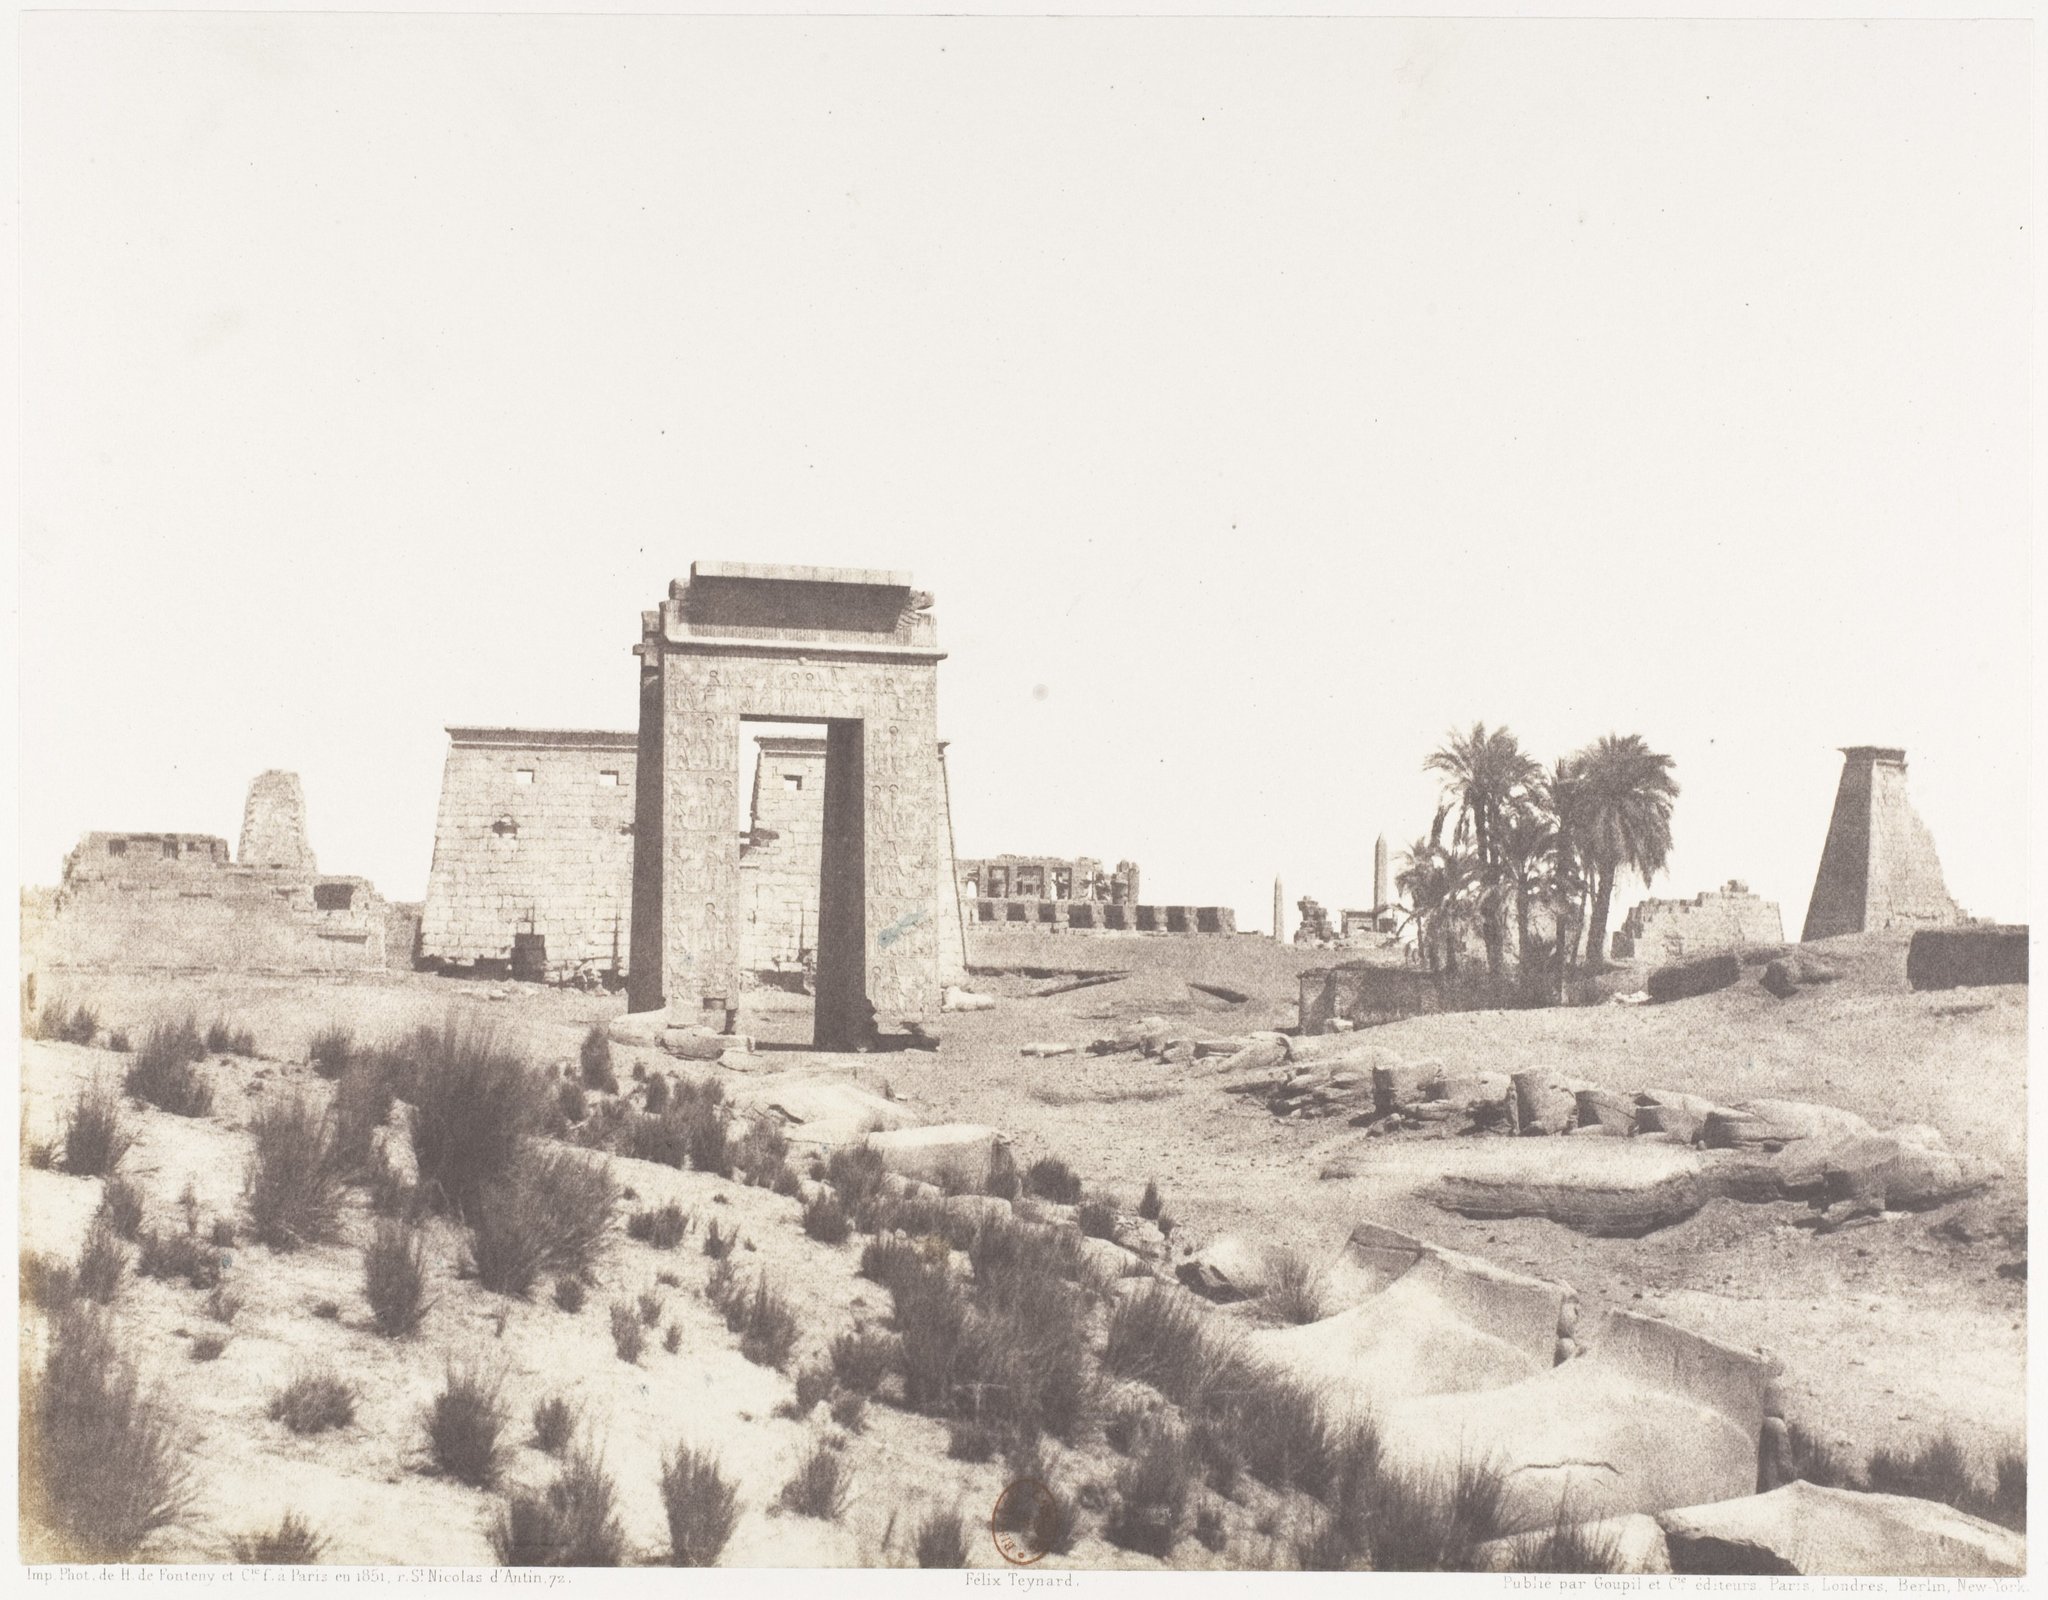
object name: photograph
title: Karnak (Thèbes), Vue Générale des Ruines Prise du Point B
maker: félix teynard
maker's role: artist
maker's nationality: french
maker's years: 1817-1892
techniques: paper negative, salted paper print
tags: architecture,ruins